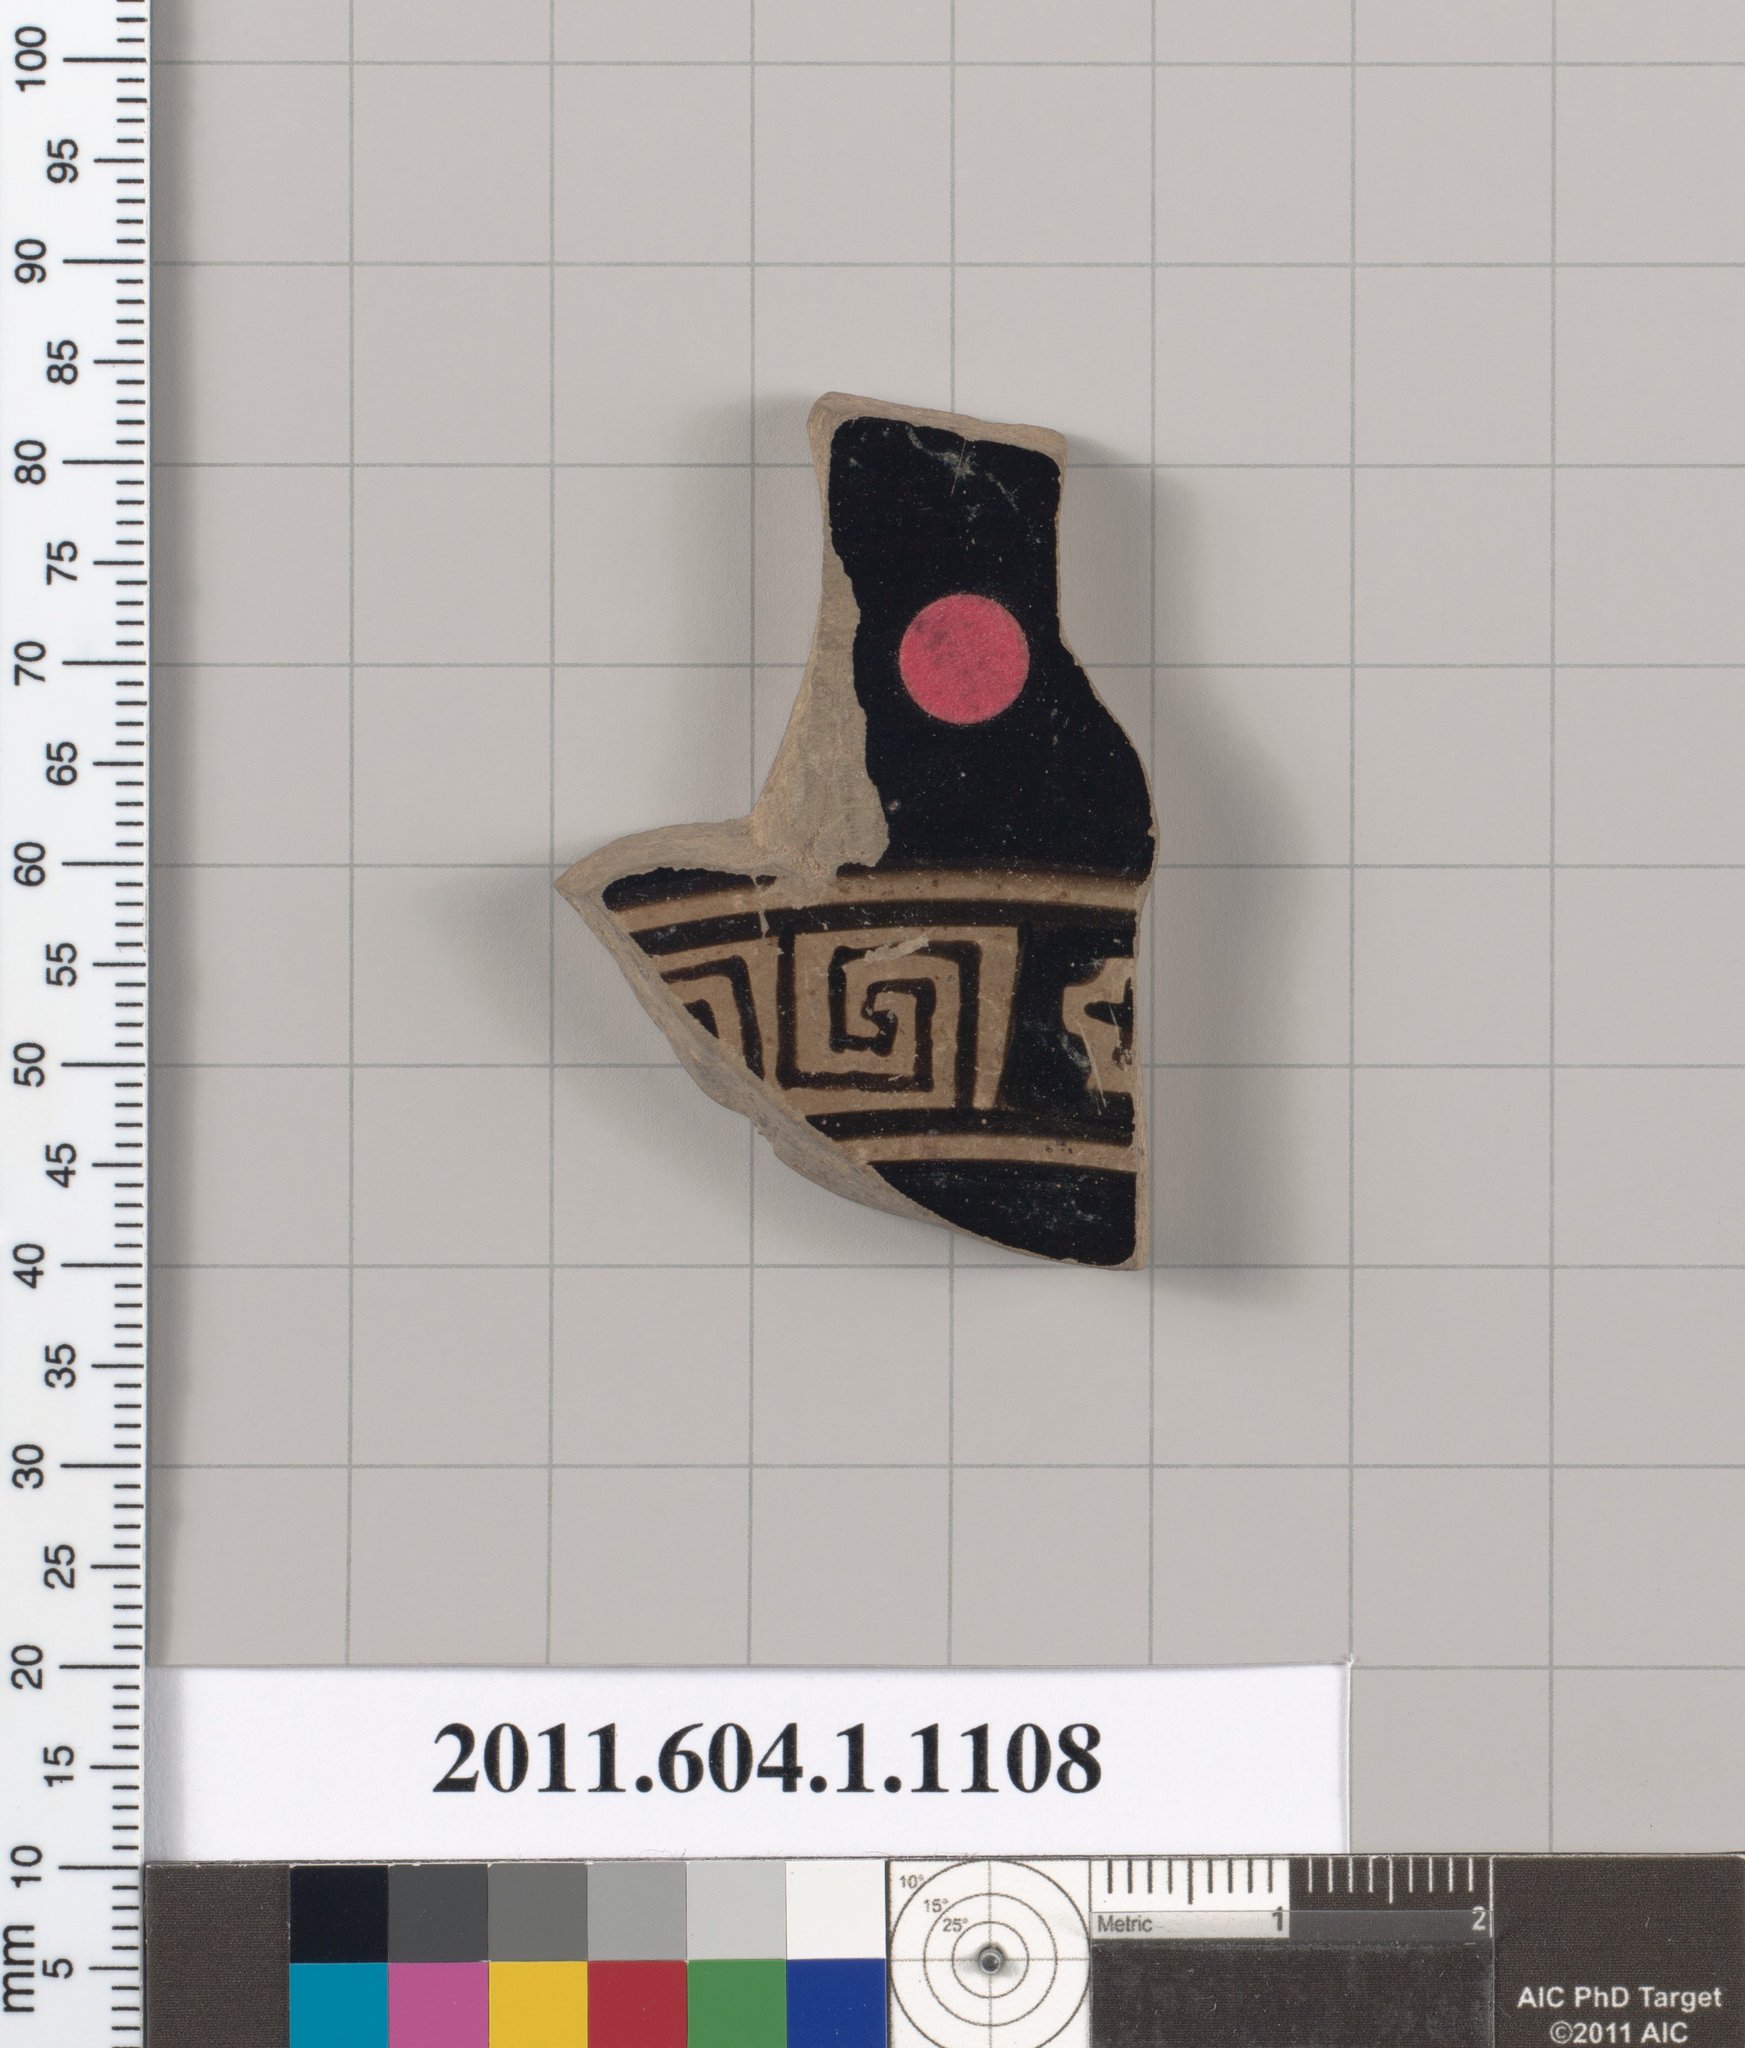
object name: kylix fragment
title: Terracotta fragment of a kylix (drinking cup)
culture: greek, attic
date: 490-480 BCE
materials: terracotta